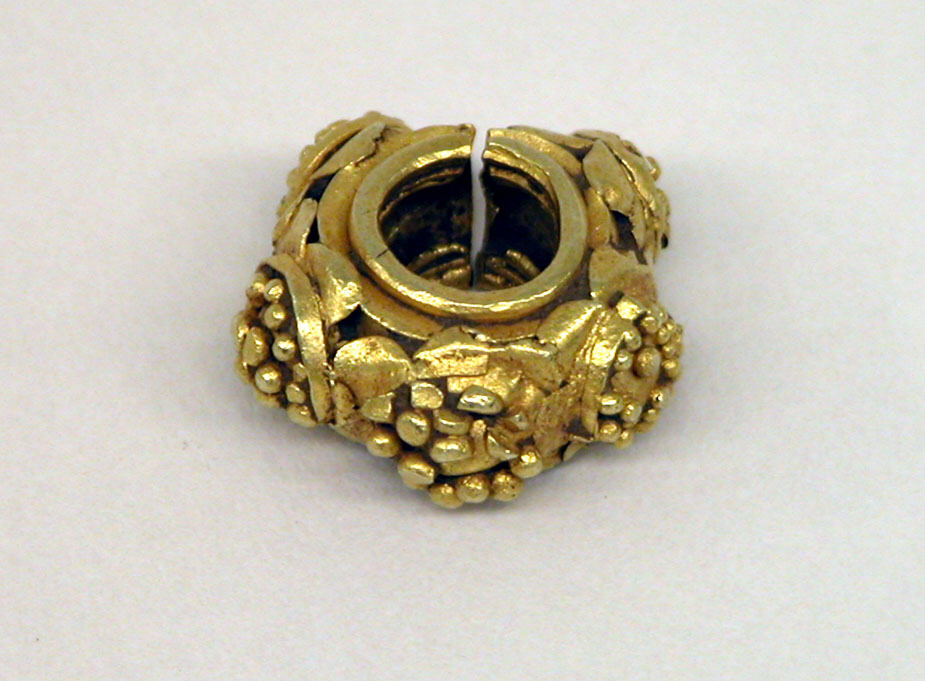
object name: ear ornament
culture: indonesian, javanese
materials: gold